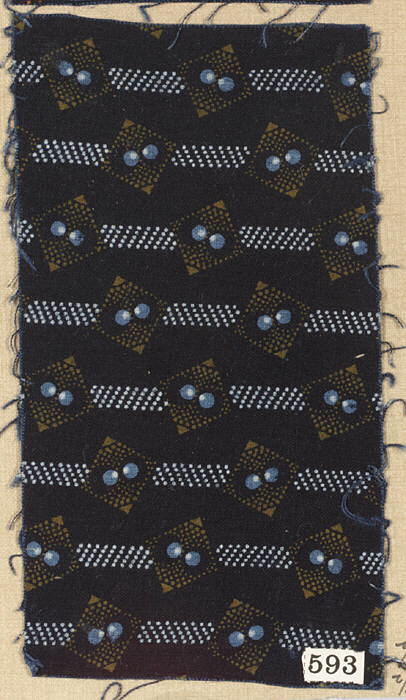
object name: piece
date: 1801-1900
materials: cotton